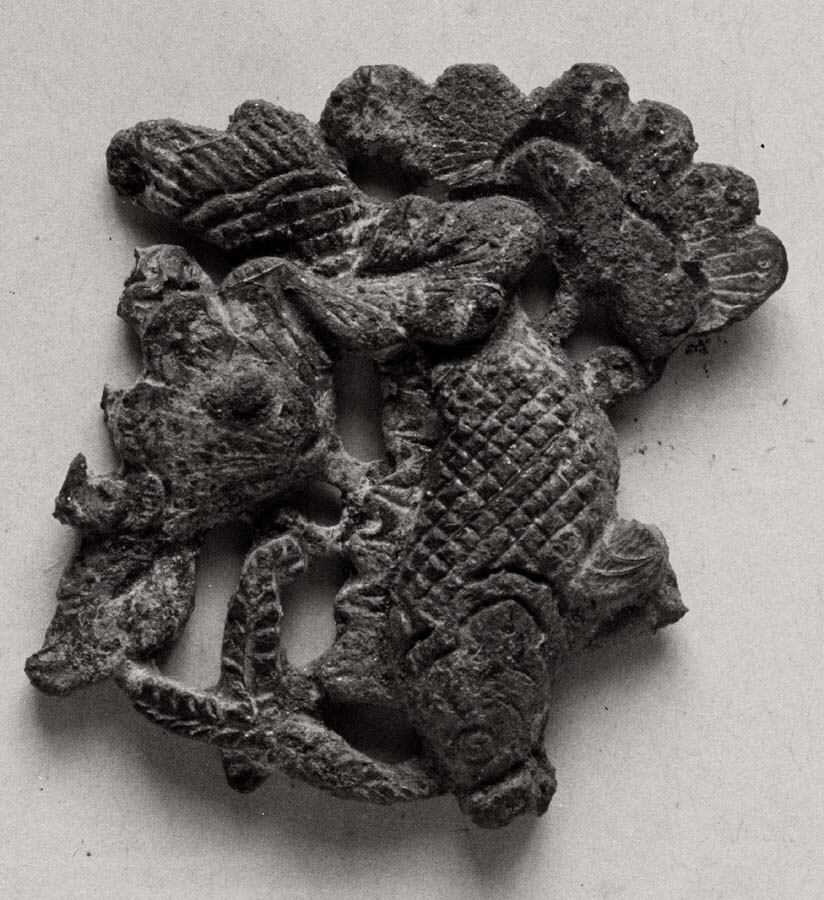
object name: ornament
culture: korean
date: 918-1392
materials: bronze